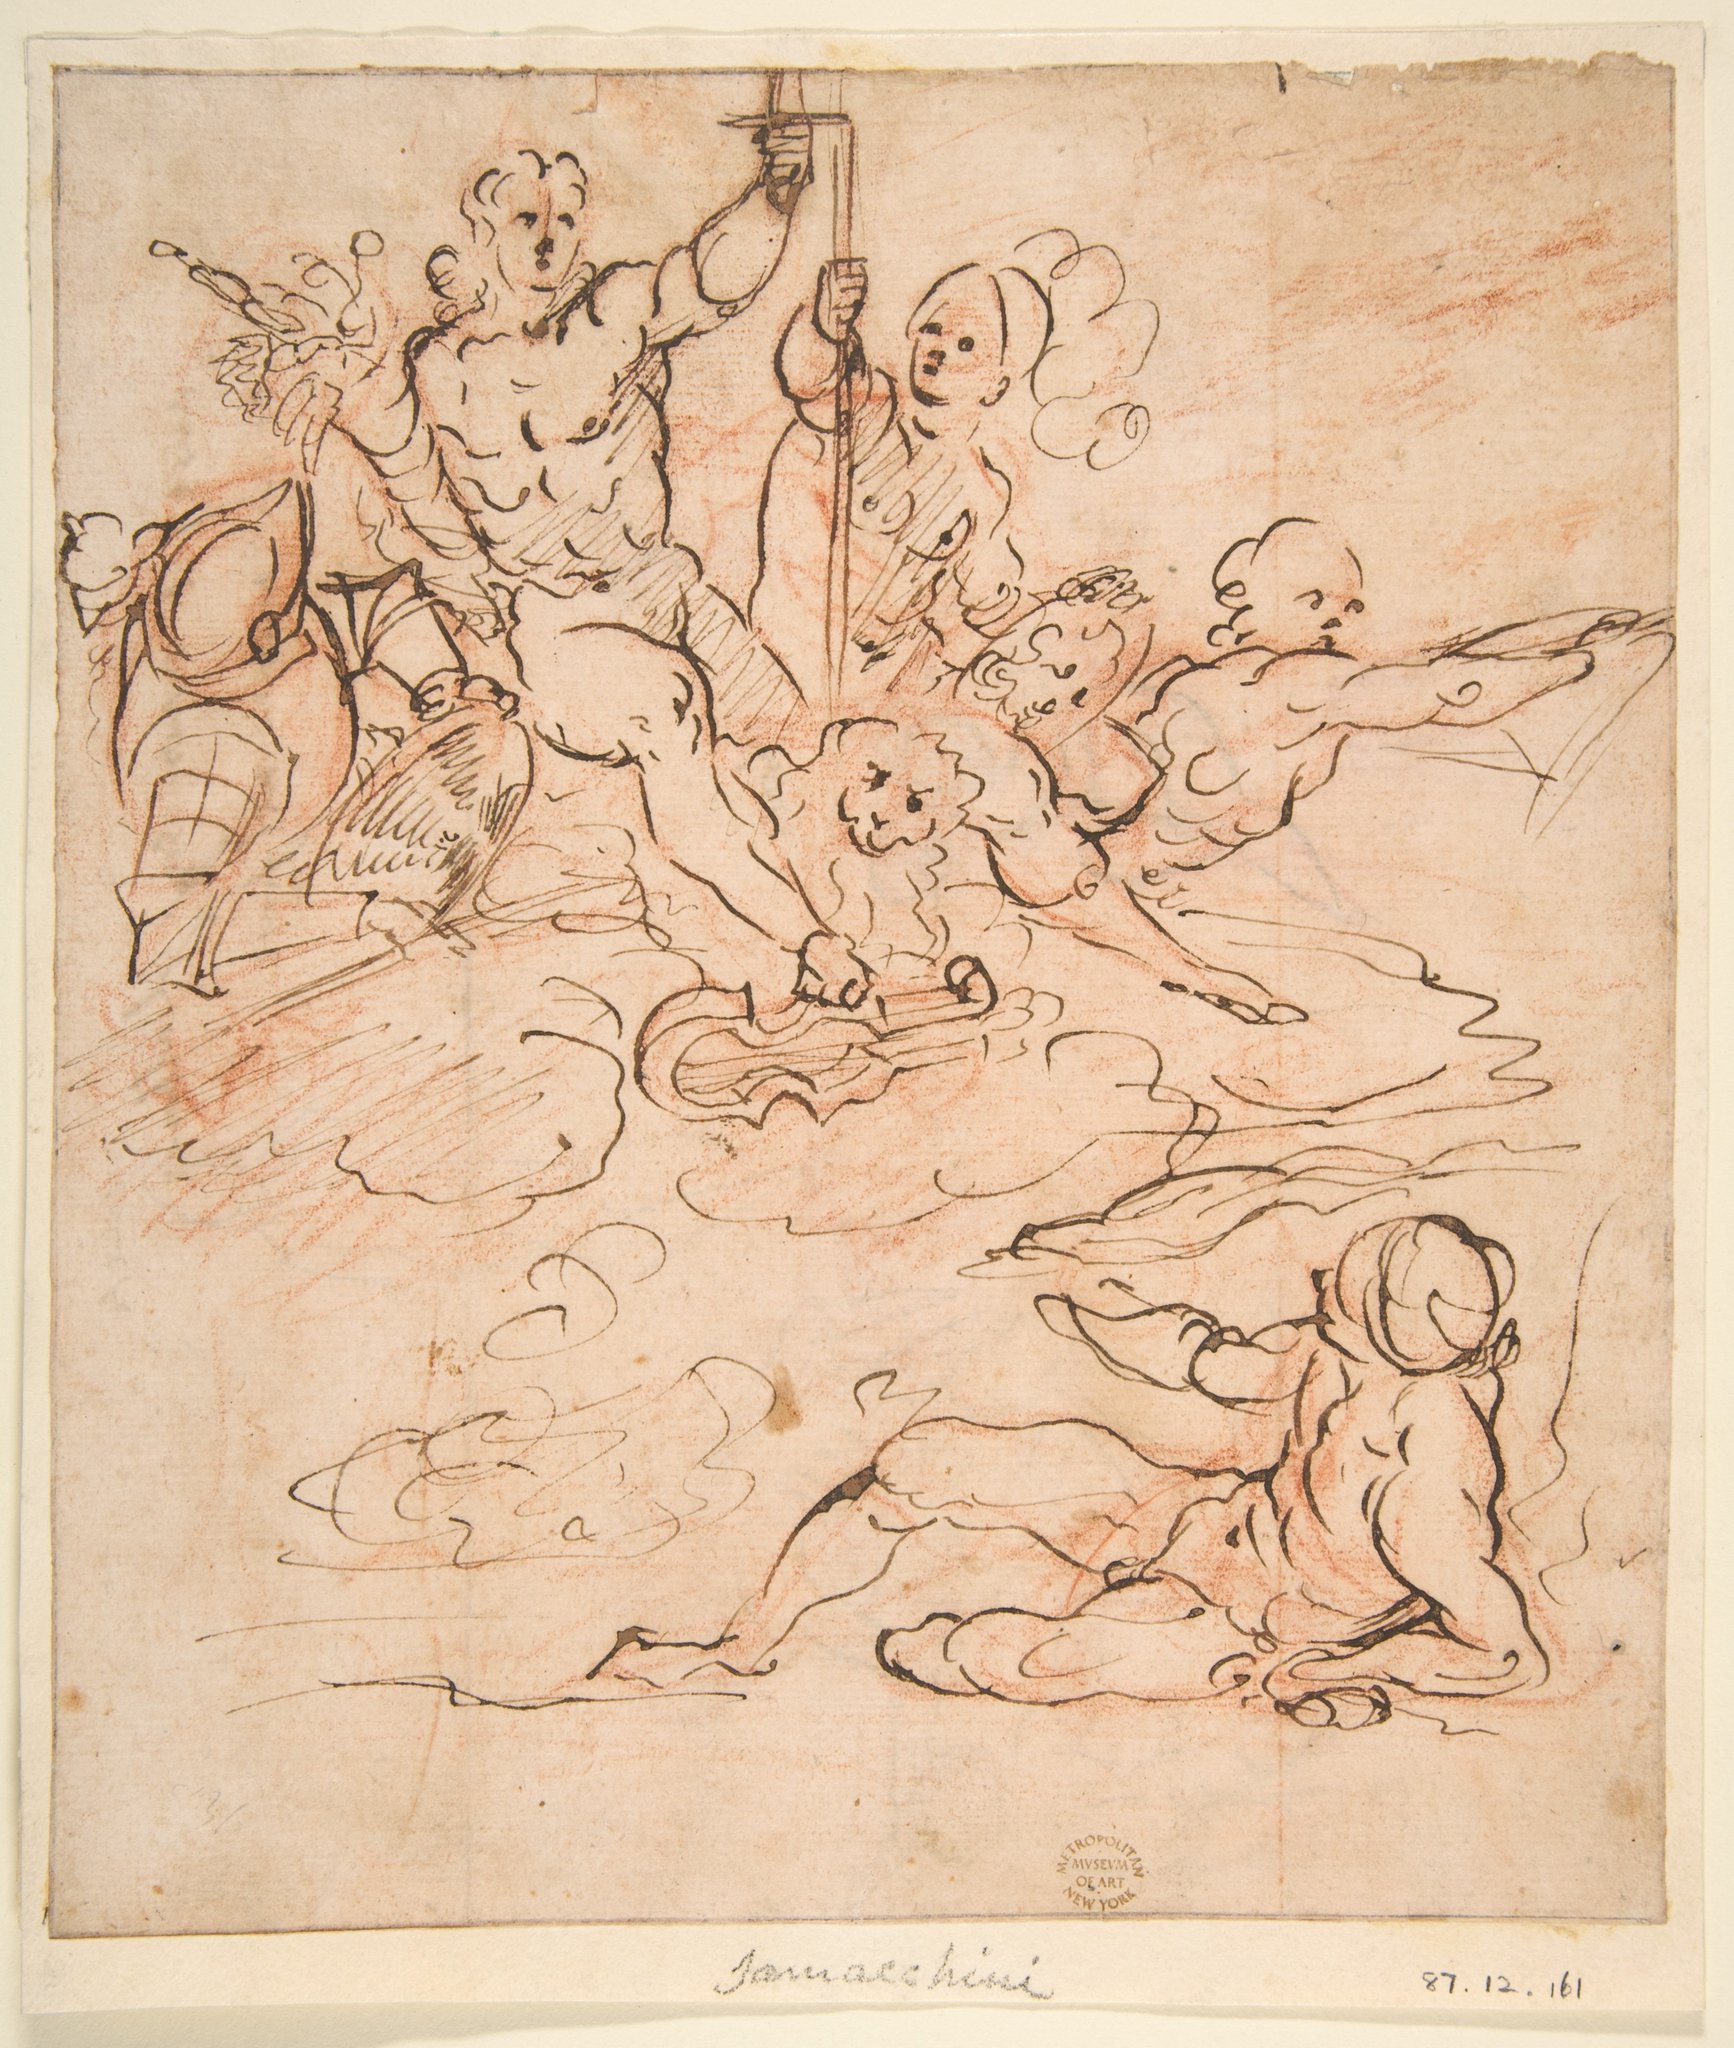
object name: drawing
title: Allegory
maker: orazio samacchini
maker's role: artist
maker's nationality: italian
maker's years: 1532-1577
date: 1532-1577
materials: chalk, ink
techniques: pen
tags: male nudes,lions